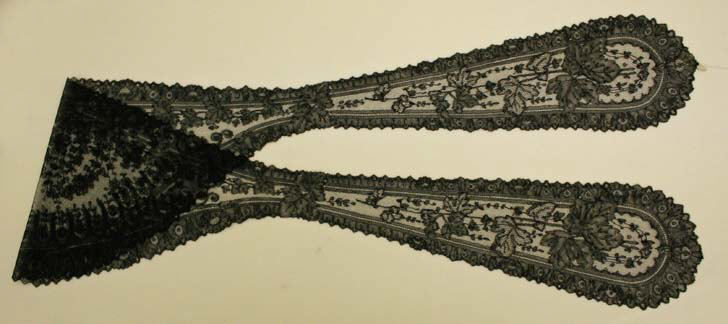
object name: cap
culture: french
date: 1801-1900